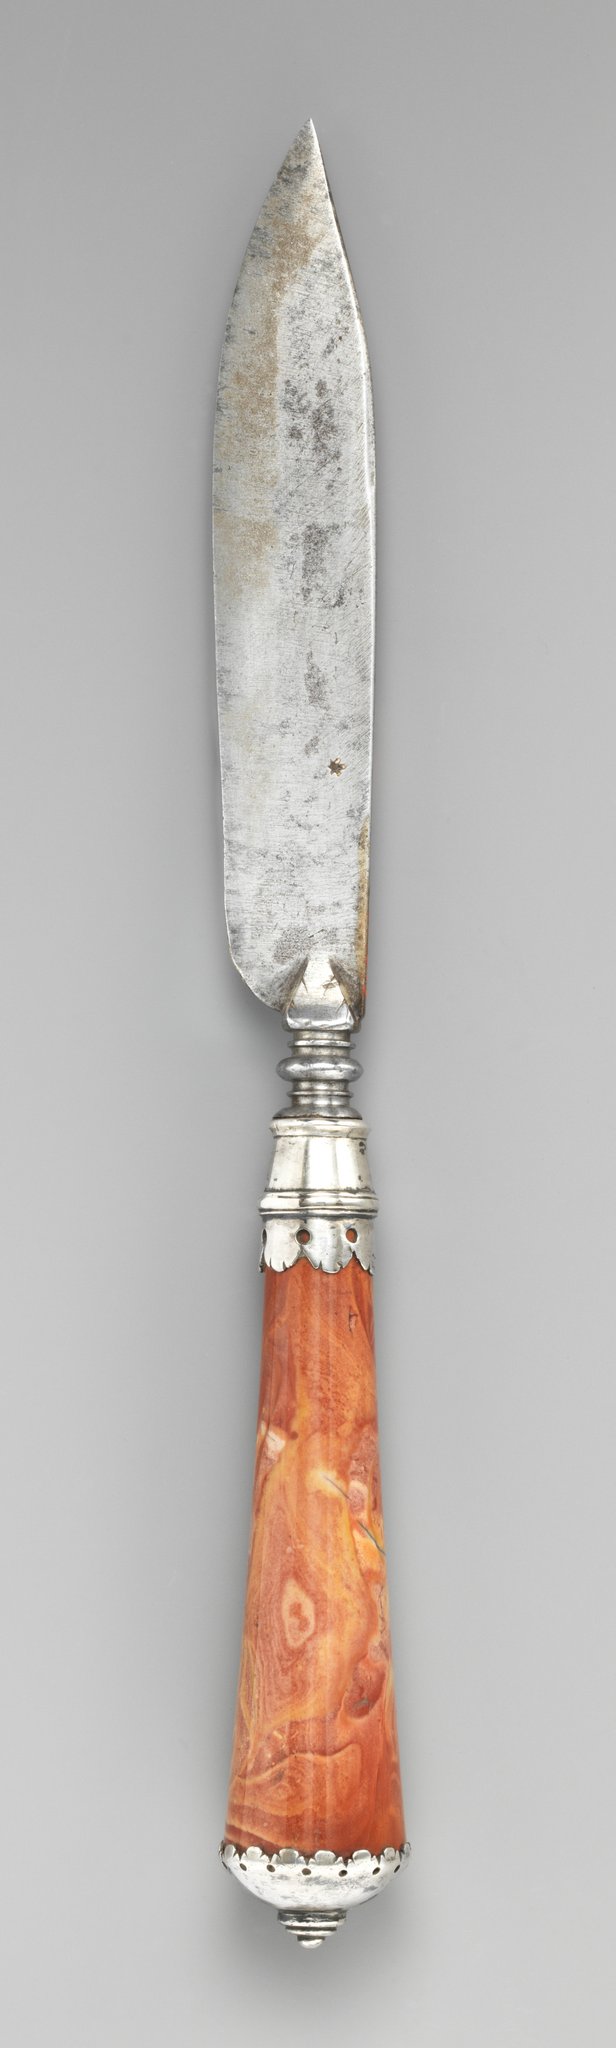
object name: table knife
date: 1667-1700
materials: stone, metal, pewter, steel